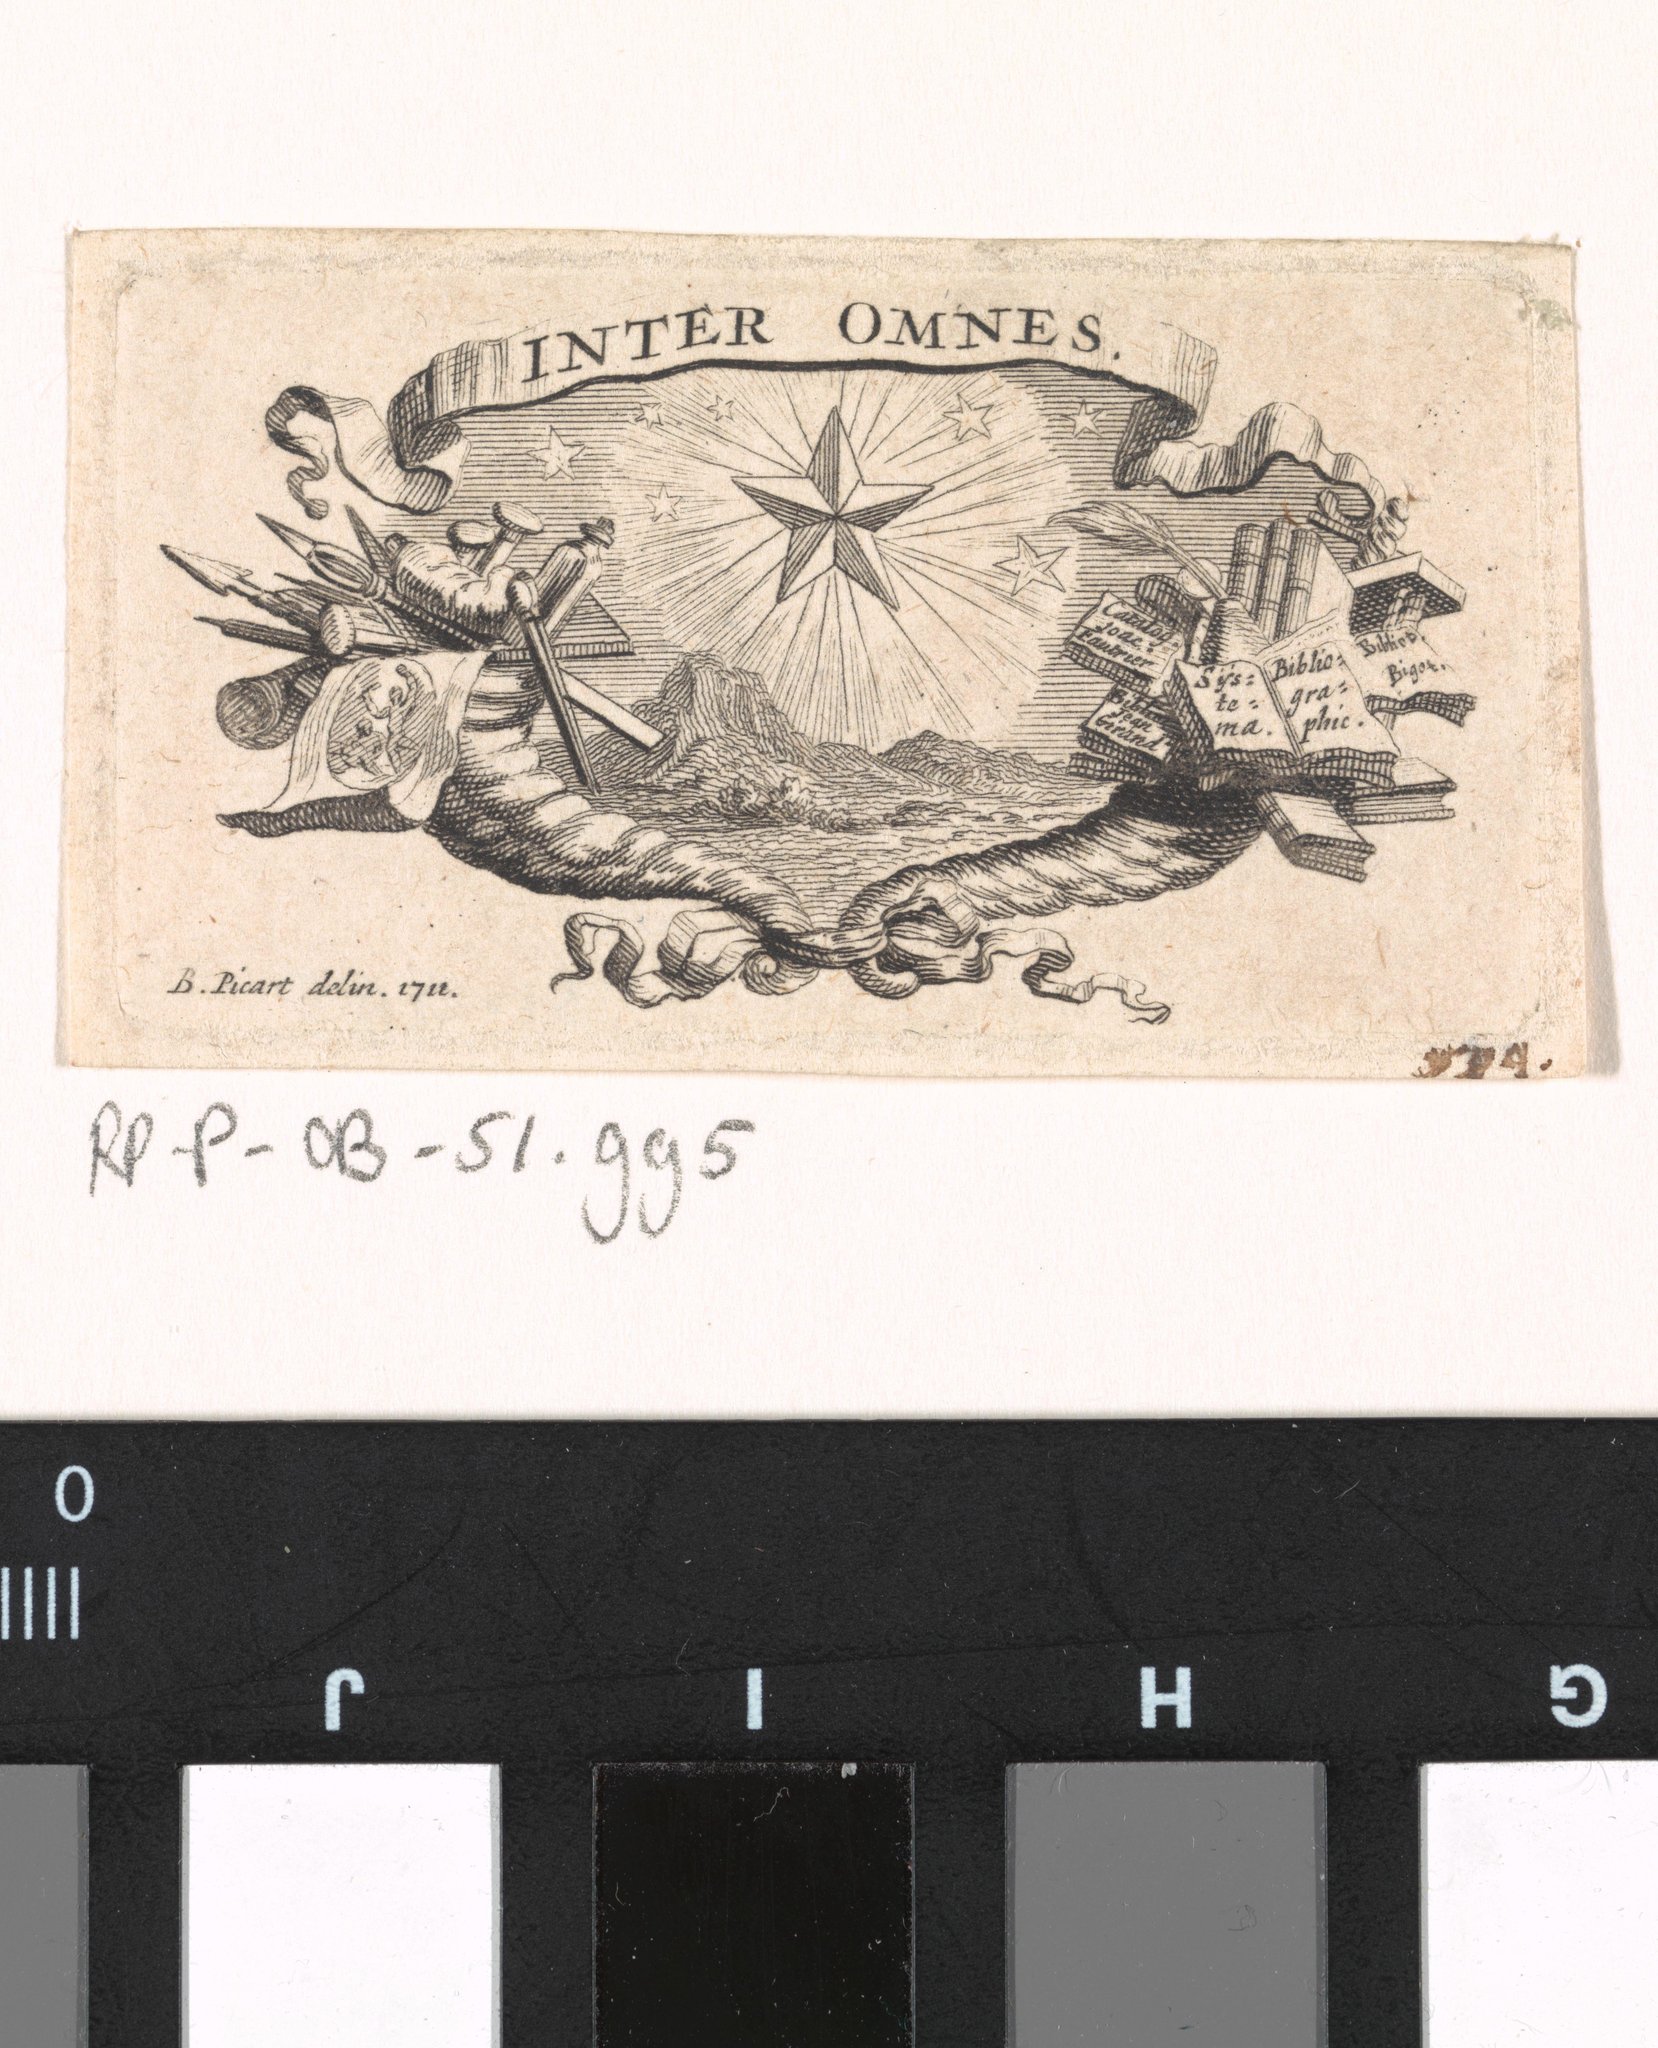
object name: print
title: Stralende ster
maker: bernard picart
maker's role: draughtsman, print maker, publisher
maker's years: 1673-1733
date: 1711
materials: paper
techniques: engraving, etching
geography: amsterdam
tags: ornaments ~ art, stars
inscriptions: collector's mark: Lugt 2228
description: Vignet van Bernard Picart met in het centrum een grote ster temidden van kleine sterren stralend boven een heuvelachtig landschap. Daaromheen ornamenten met hoornen des overvloeds met graveer- en boekverkopersattributen en het devies: Inter Omnes.